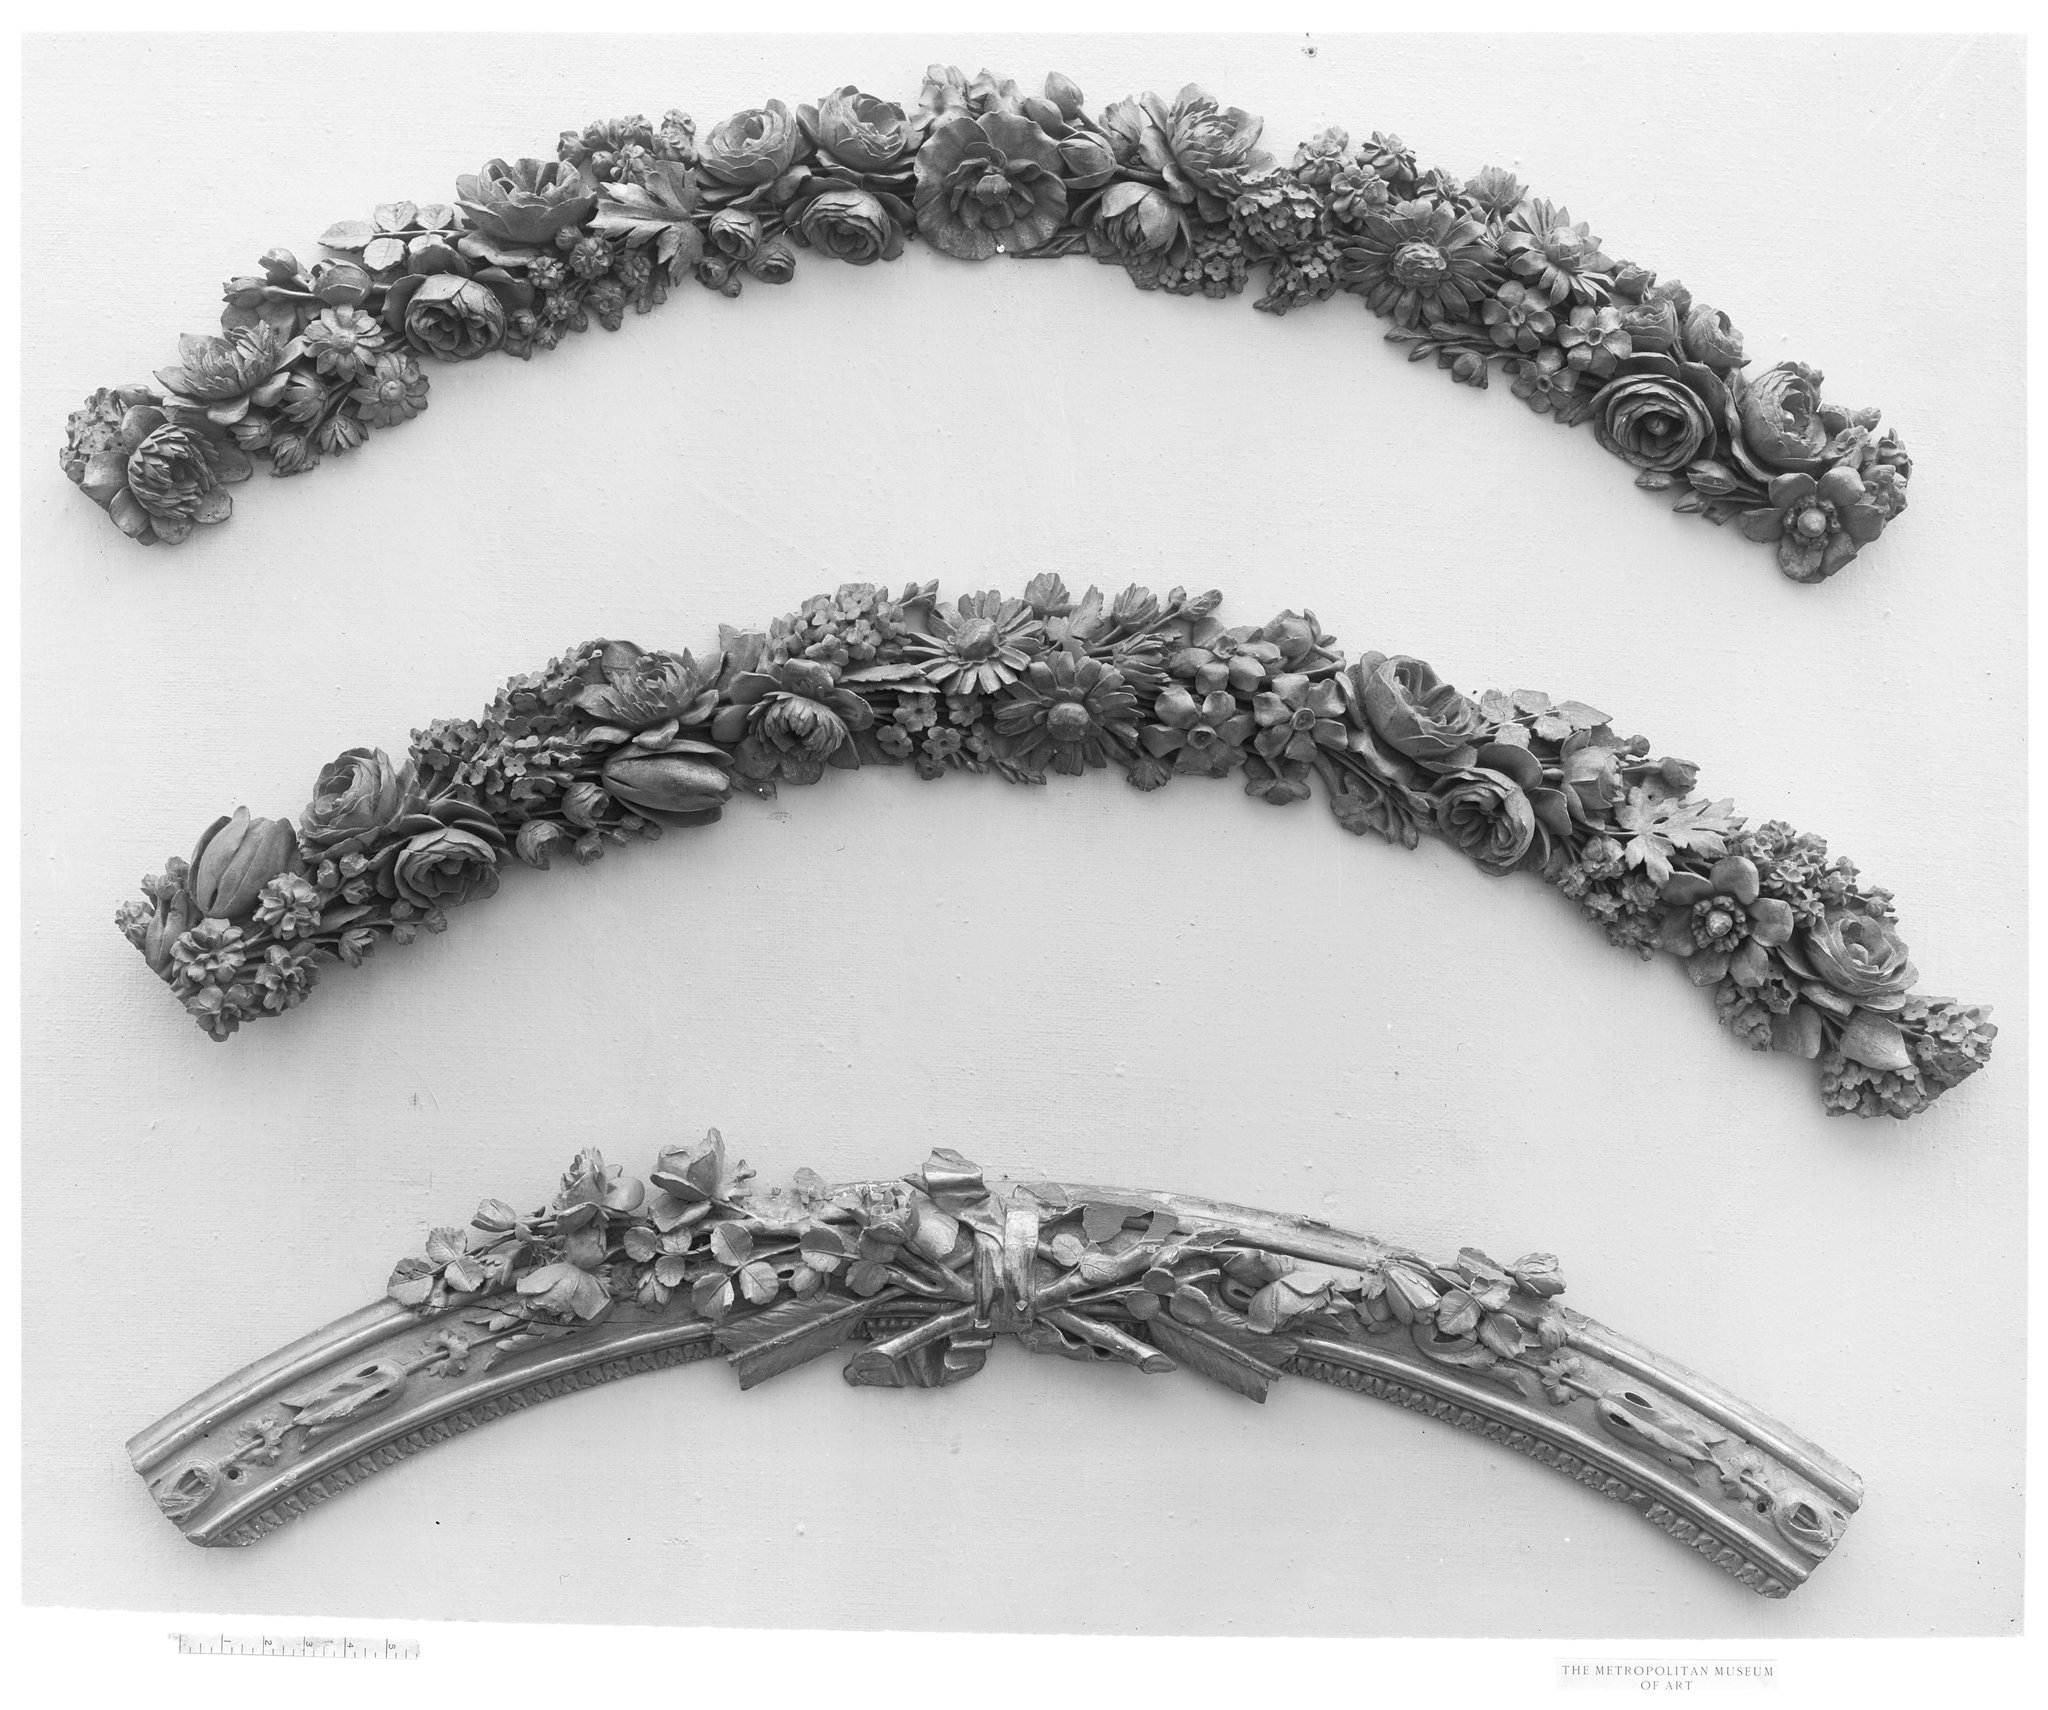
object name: frame fragment, mirror top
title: Circular frame fragment (mirror top?)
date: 1701-1800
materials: gilt, wood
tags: garlands,flowers